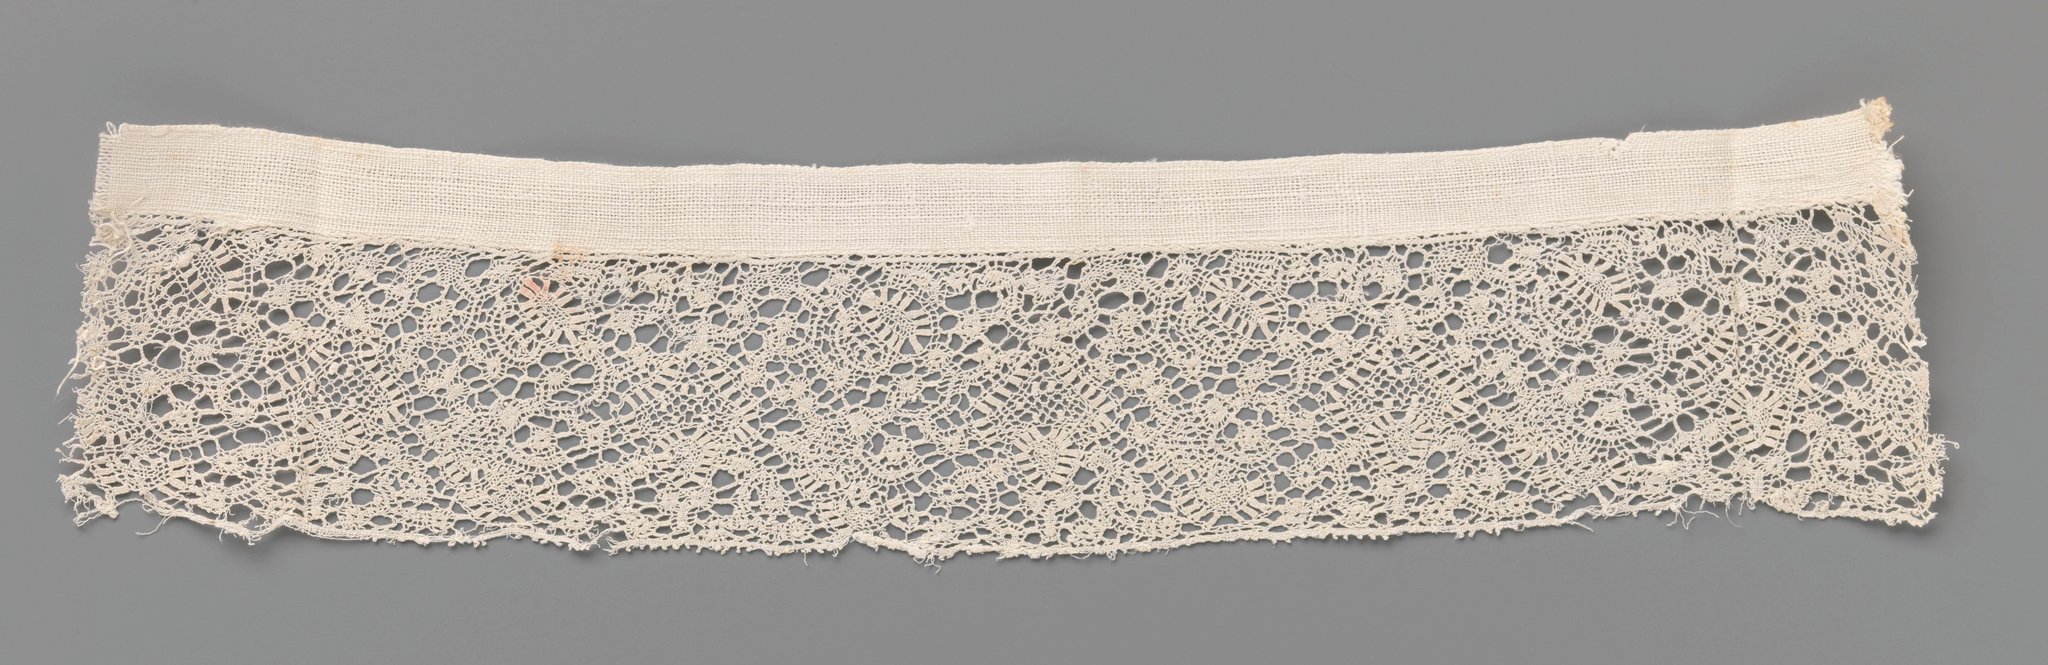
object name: strip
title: Strook kloskant met schuine ovalen en harten met druppel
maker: Anonymous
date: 1660-1690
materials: linen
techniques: lace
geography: southern netherlands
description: Strook naturelkleurige kloskant, Binche-kant. Het zich herhalende patroon bestaat uit wirwar van kleine motiefjes gemaakt met verschillende siergronden. Smalle sierbandjes met rechthoekjes, gemaakt in vormslag, vormen schuin geplaatste ovalen langs de bovenkant en op de middenlijn, steeds tussen twee ovalen in, een omgekeerd hart met een druppel tussen de rondingen. De motieven zijn met elkaar verbonden door een onregelmatige siergrond, een sneeuwvlokkengrond. De onderzijde van de strook is recht afgewerkt en voorzien van picots. De bovenrand is afgewerkt met een linnen bandje.